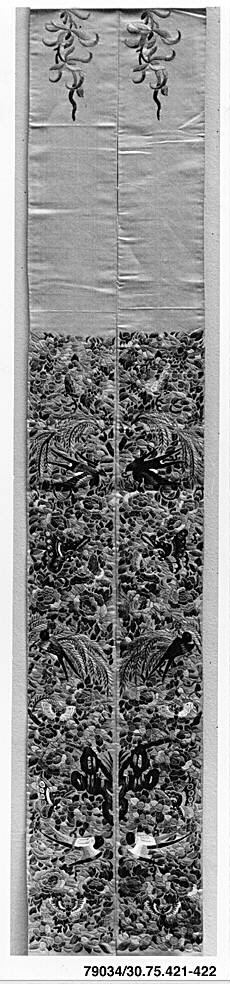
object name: sleeve band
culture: chinese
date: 1801-1900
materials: silk